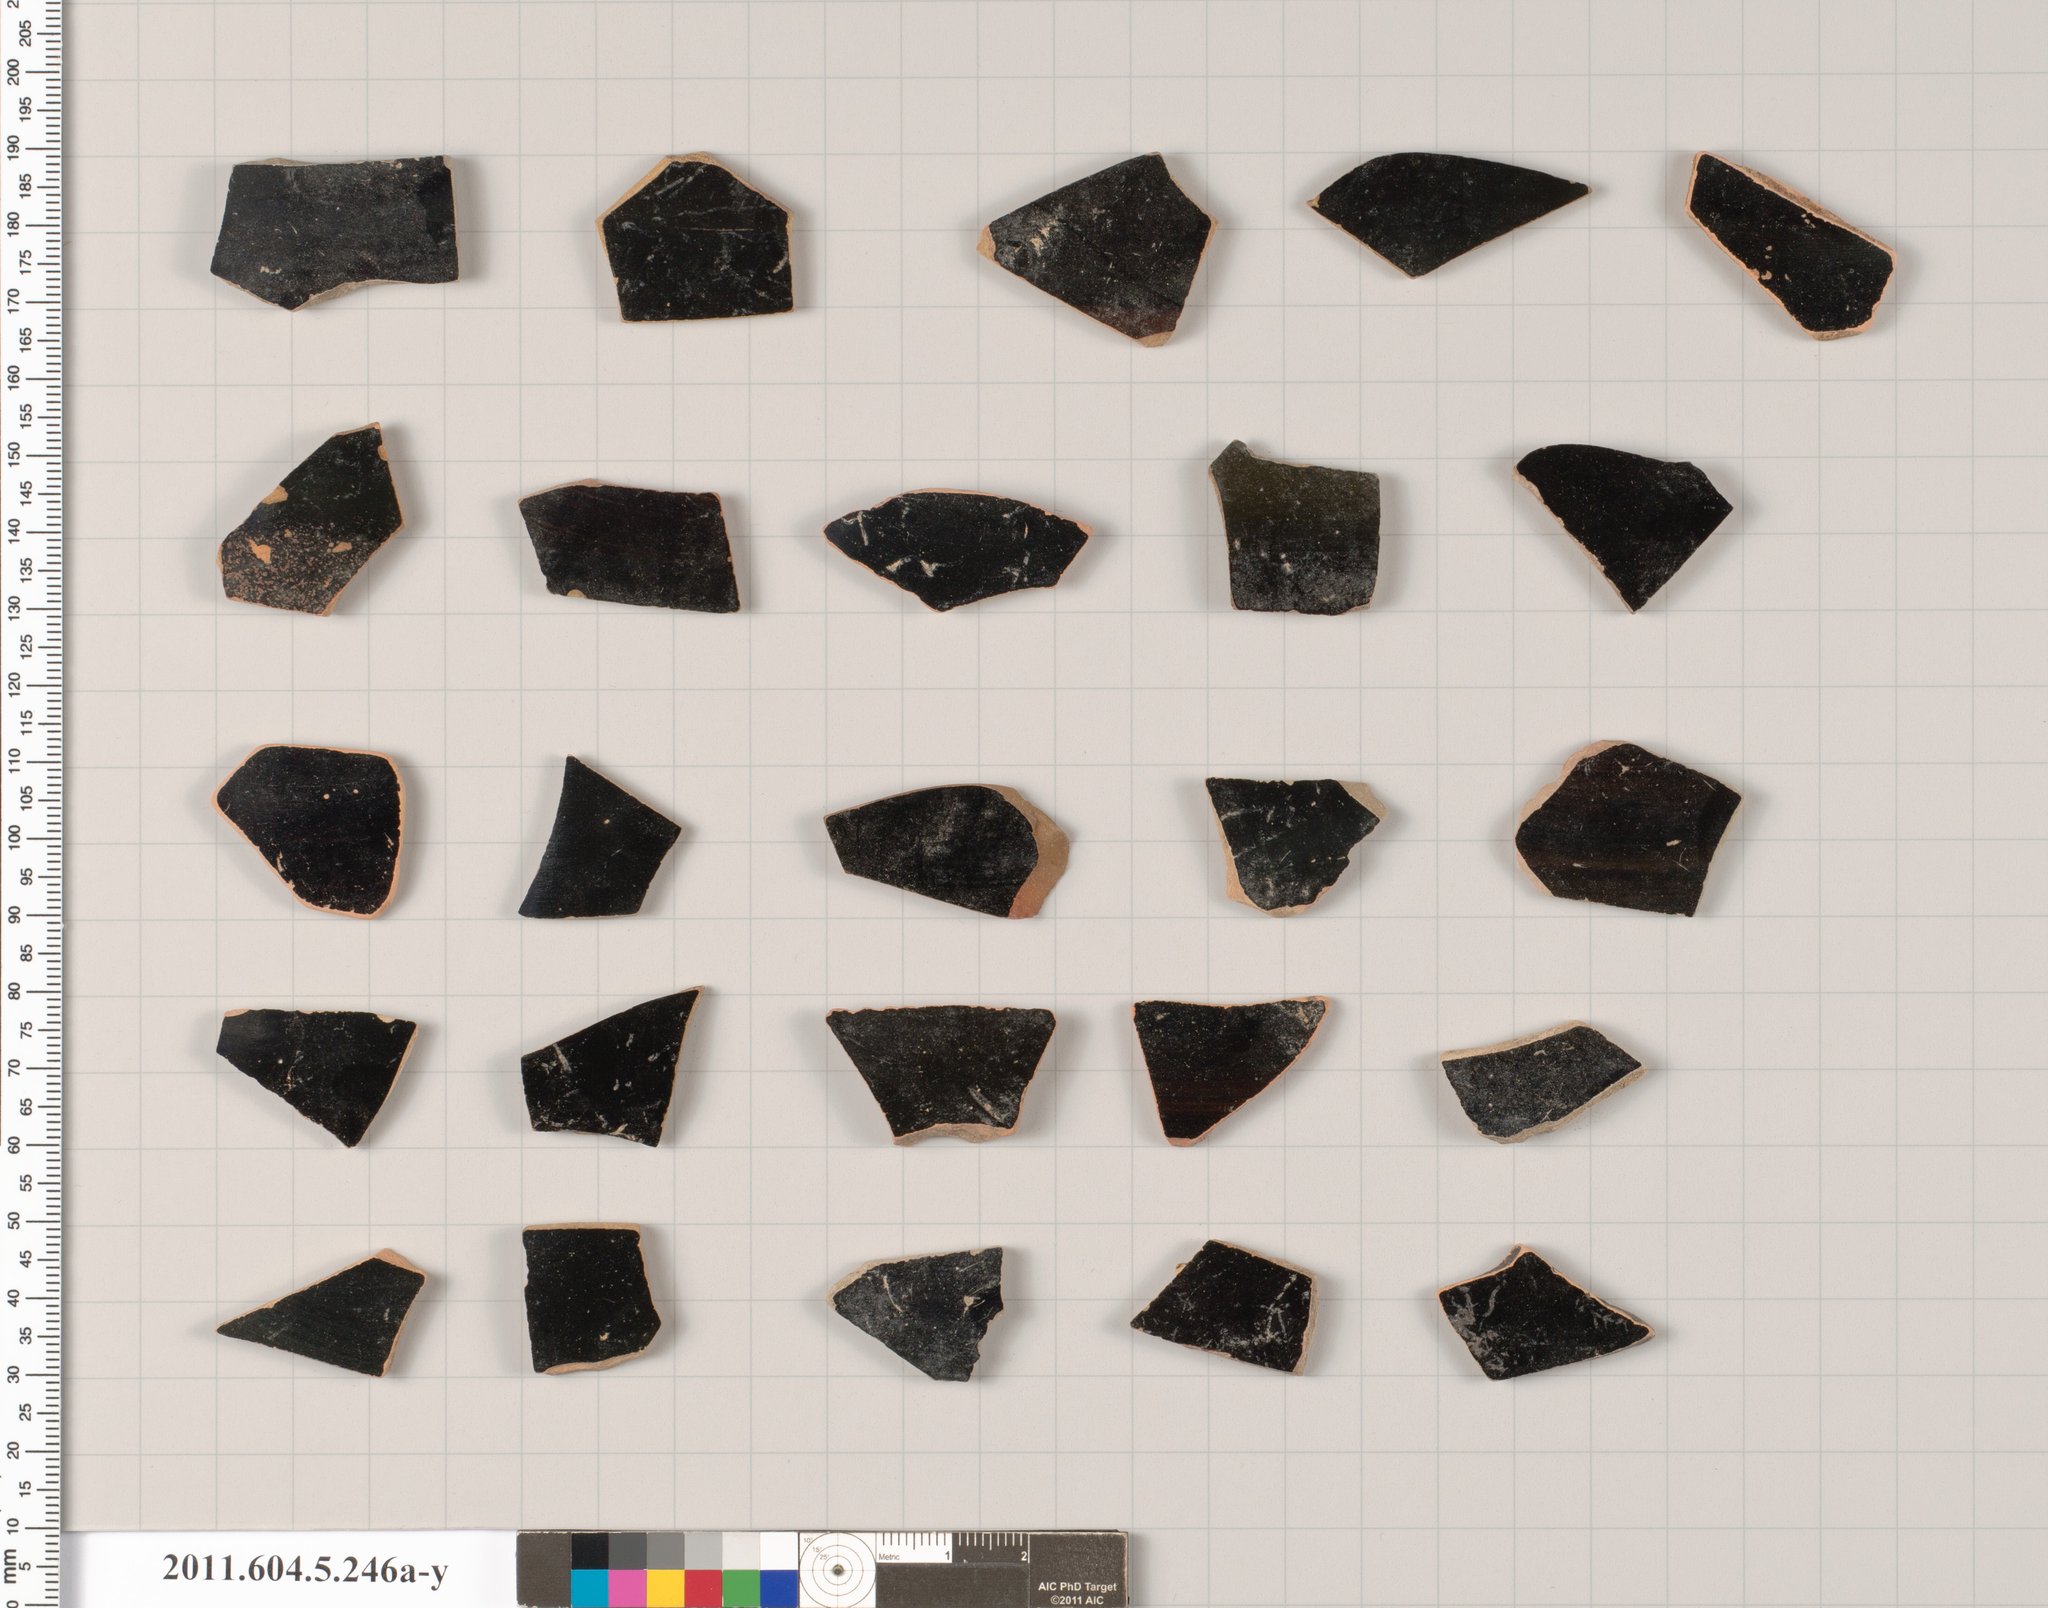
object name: kylix fragment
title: Terracotta fragments of kylikes (drinking cups)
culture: greek, attic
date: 600-401 BCE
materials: terracotta